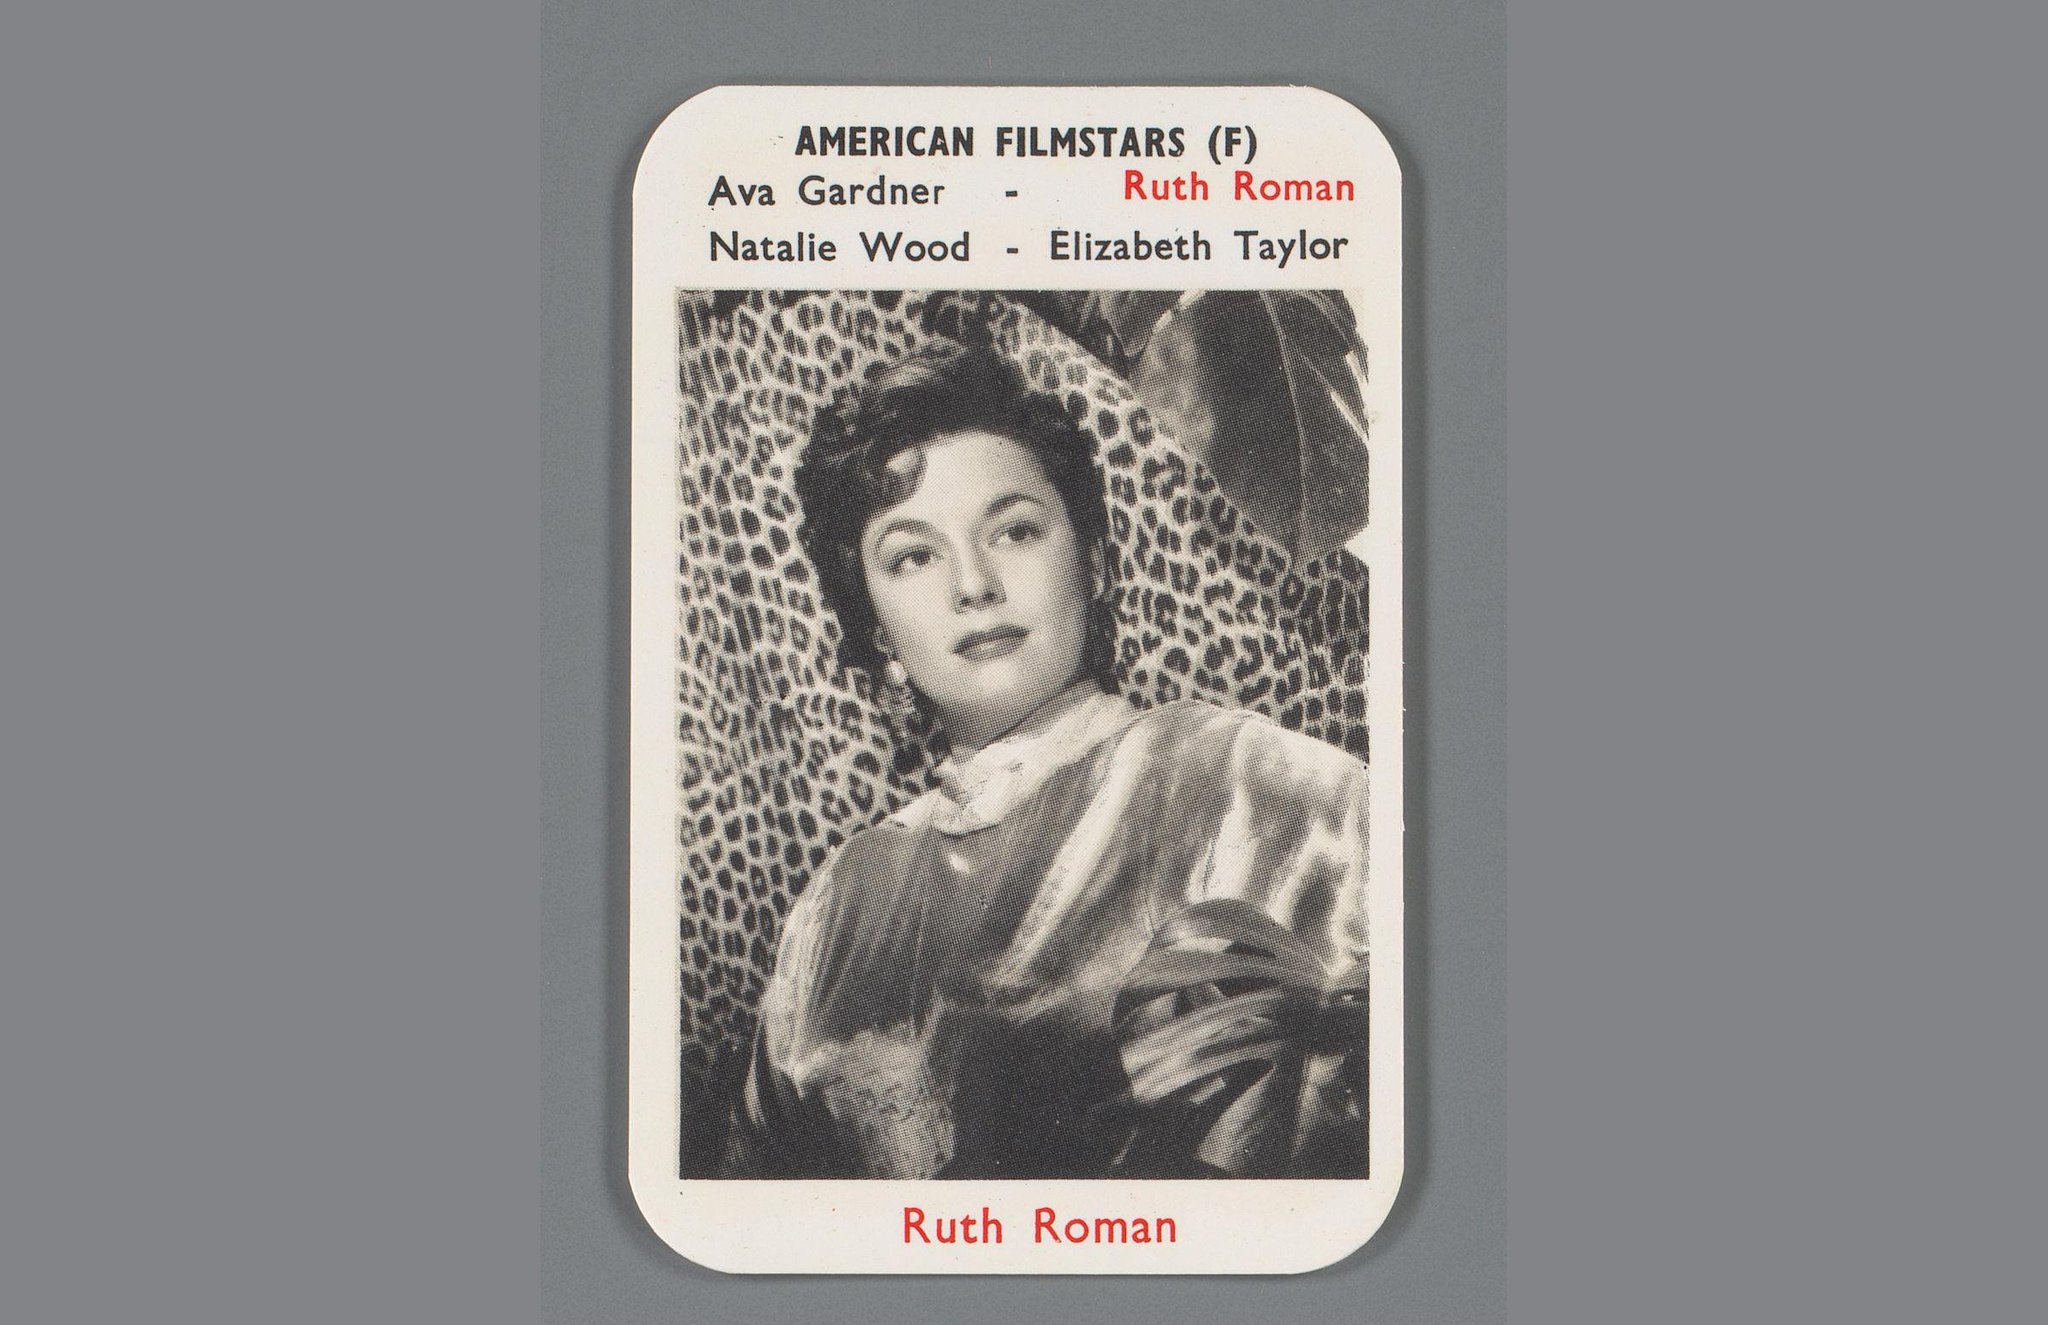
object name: playing card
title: American Filmstars (F)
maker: Anonymous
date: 1960-1970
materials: paper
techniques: autotype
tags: portrait of actor, actress